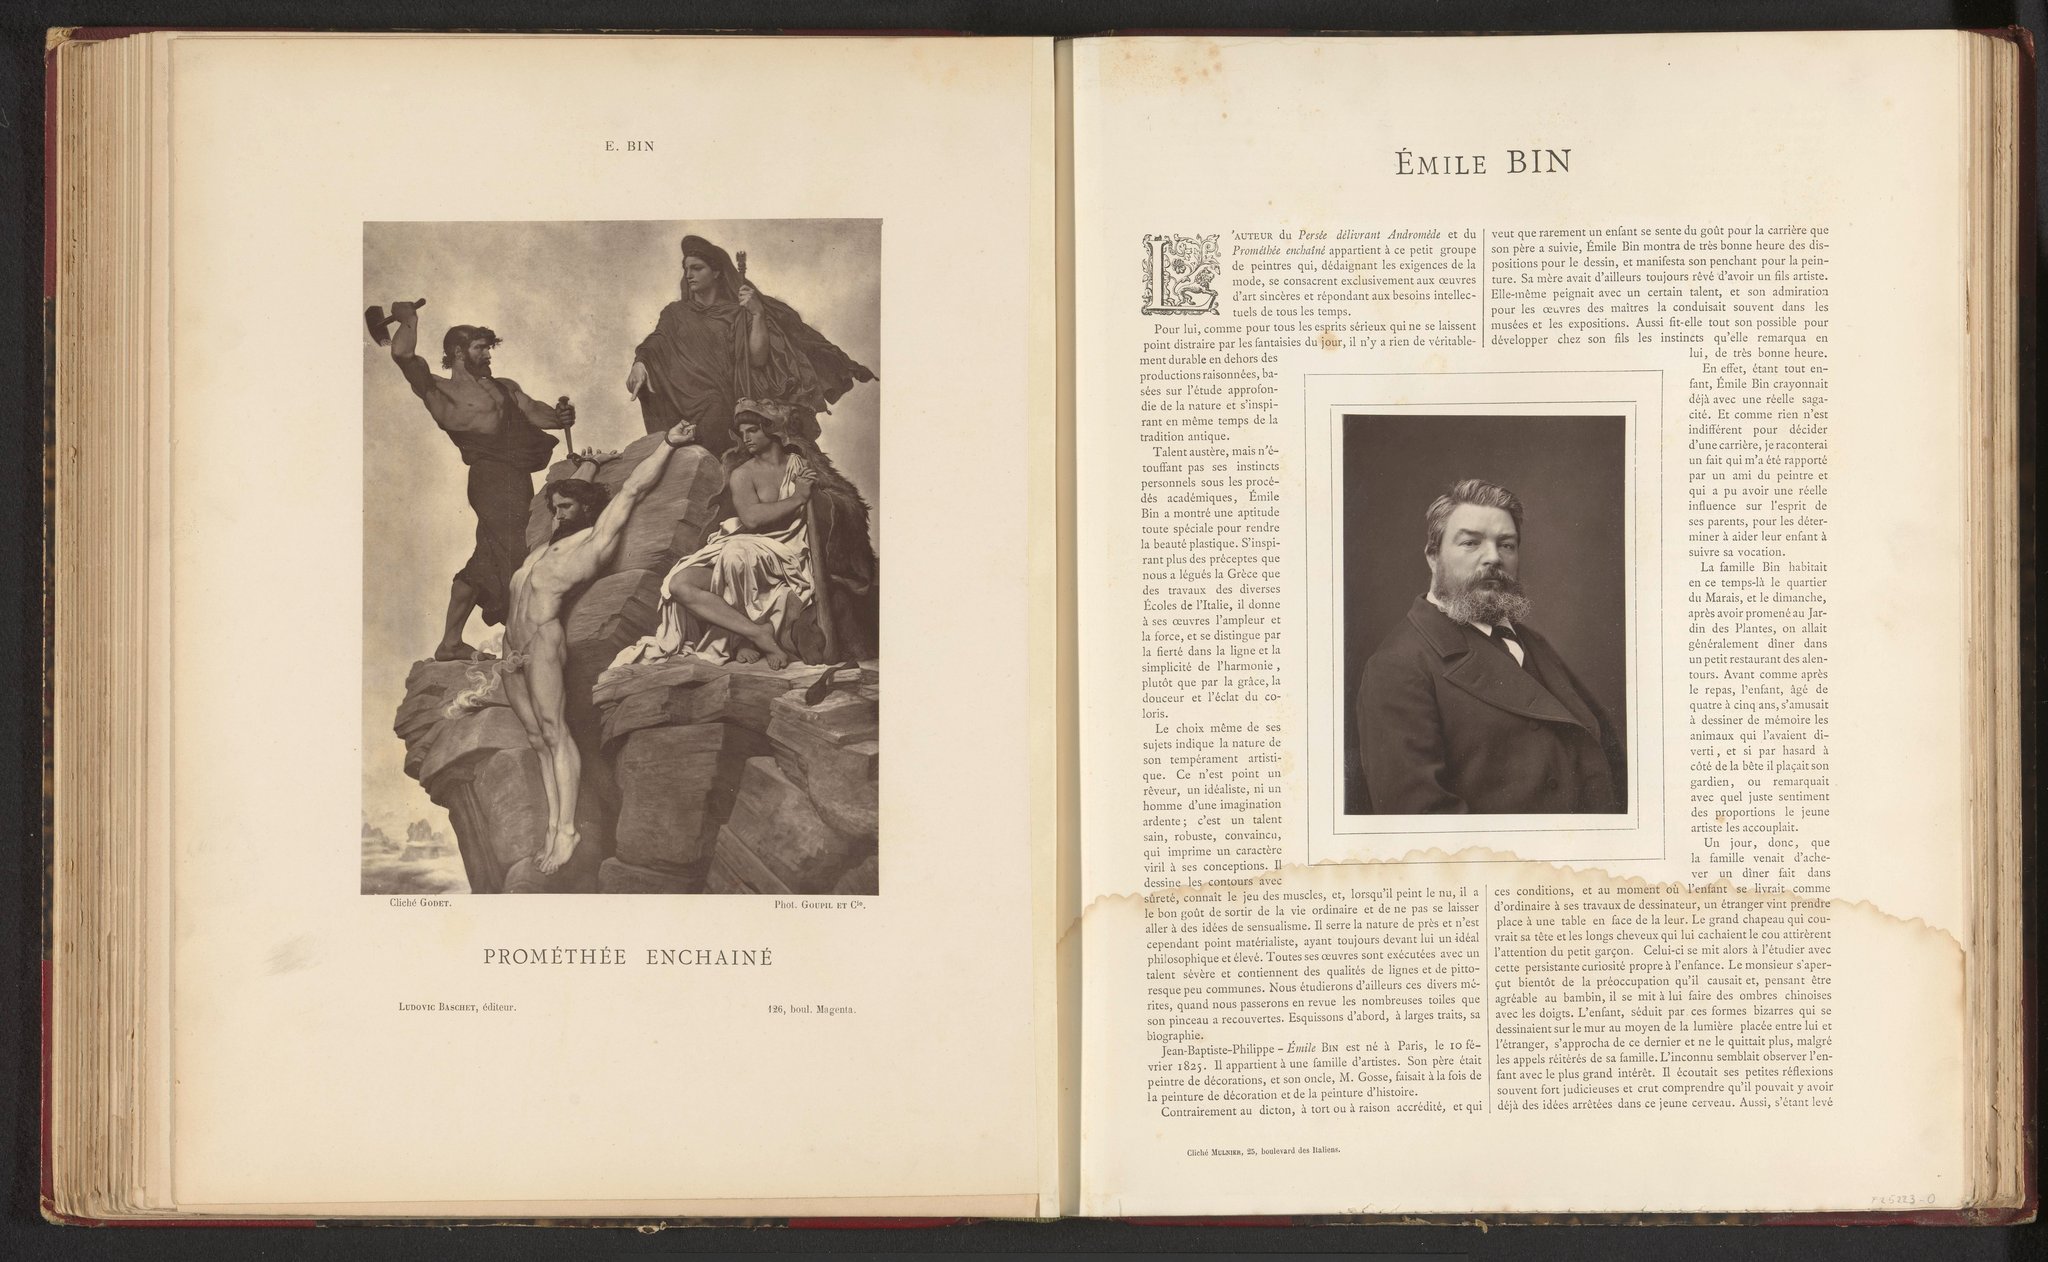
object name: reproduction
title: Prométhée Enchainé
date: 1876-1879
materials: paper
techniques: woodburytype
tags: picture, painting, (story of) prometheus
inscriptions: inscription: ‘126, boul. Magenta.-Paris.’